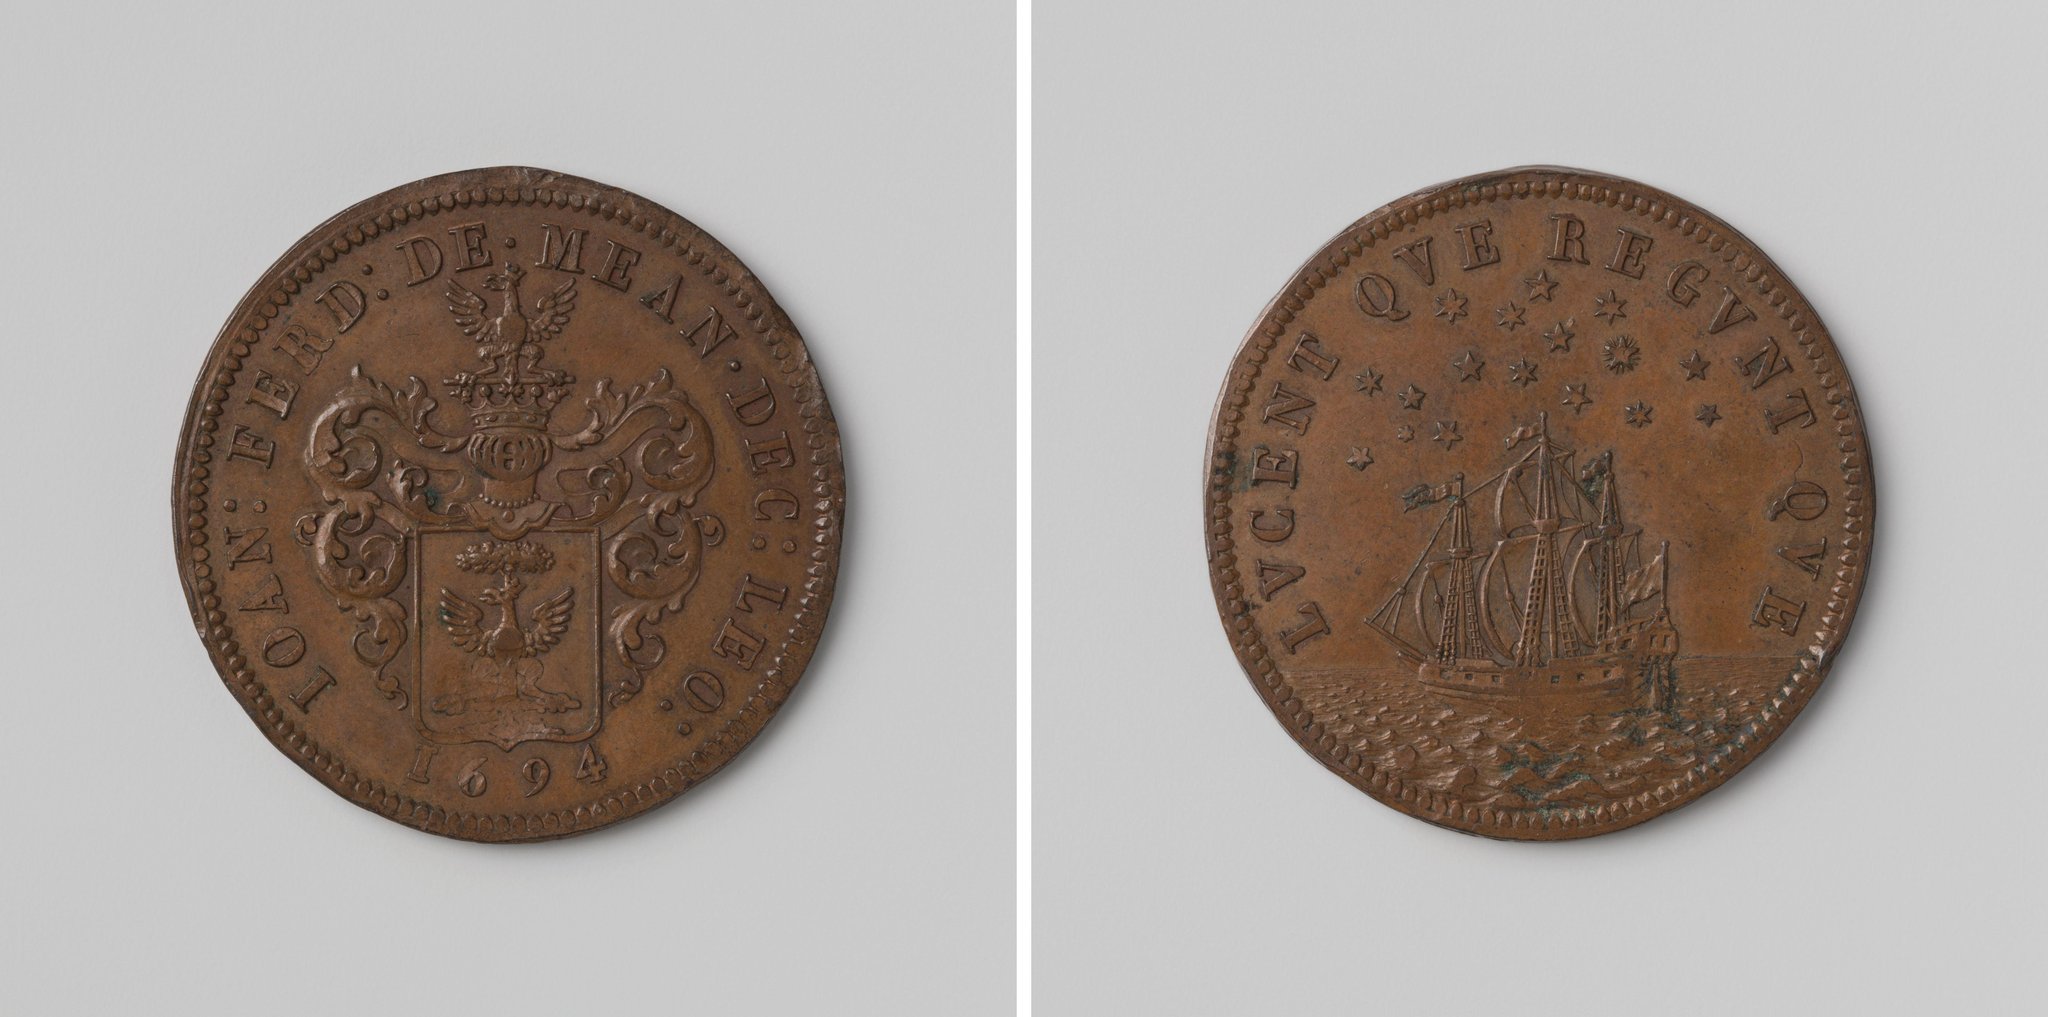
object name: jeton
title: Johan Ferdinand de Mean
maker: Anonymous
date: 1694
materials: copper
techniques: striking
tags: johan ferdinand de mean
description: Koperen penning. Voorzijde: gehelmd wapenschild binnen omschrift. Keerzijde: schip op zee onder met sterren bezaaide hemel binnen omschrift